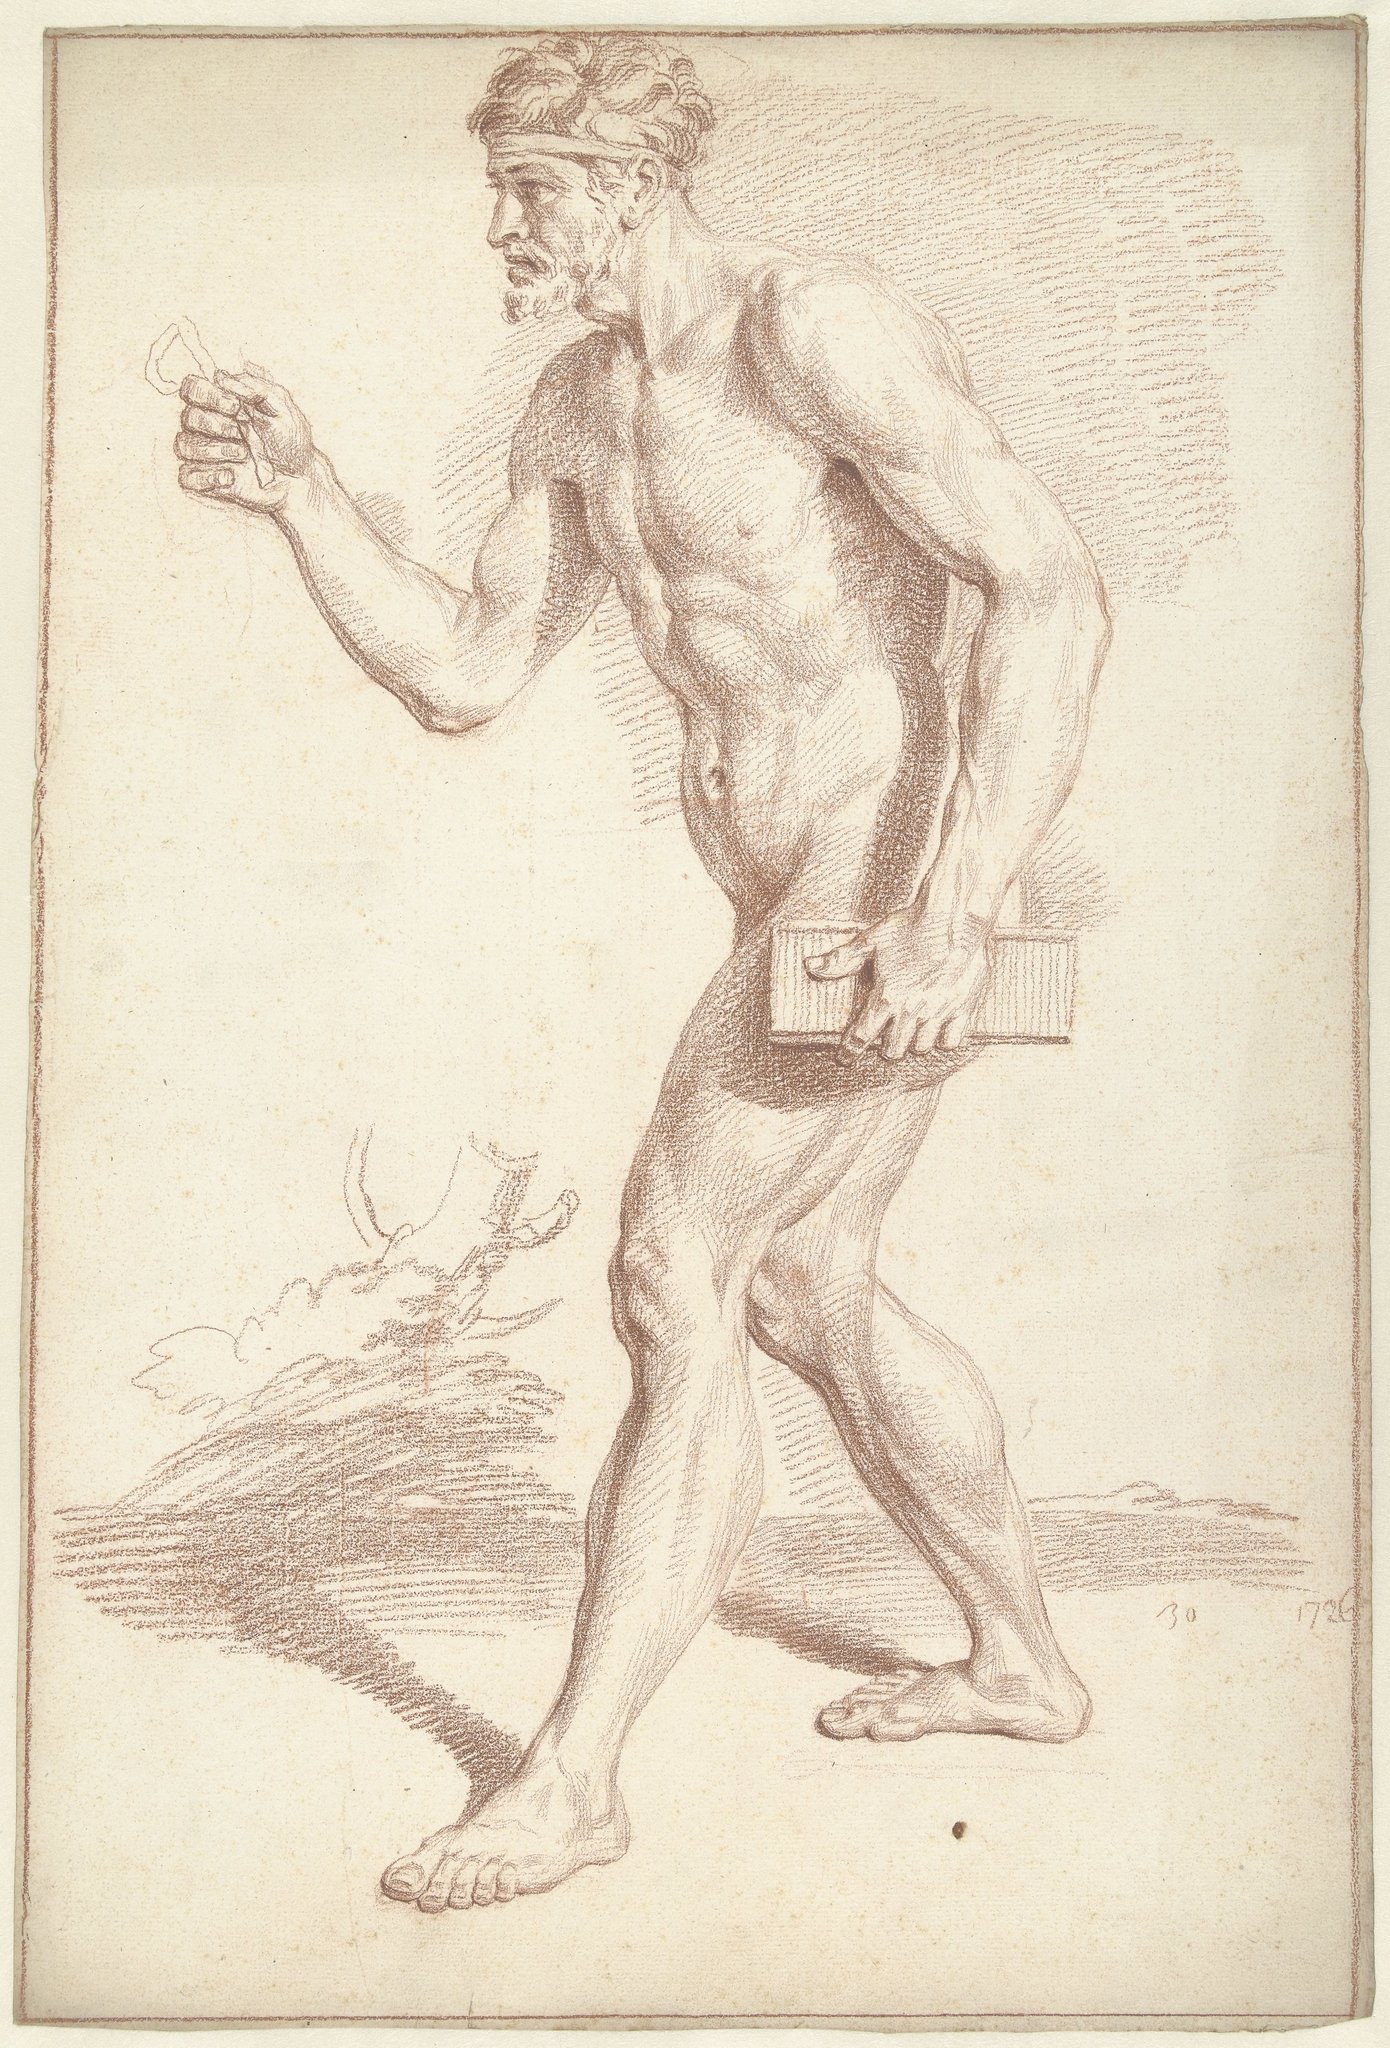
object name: drawing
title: Mannelijk naakt, lopend, naar links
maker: louis fabritius dubourg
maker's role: draughtsman, print maker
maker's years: 1693-1775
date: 1726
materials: chalk, paper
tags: the (nude) human figure; 'corpo humano' (ripa)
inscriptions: date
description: Mannelijk naakt, lopend, naar links. Opschrift: 30 1726.